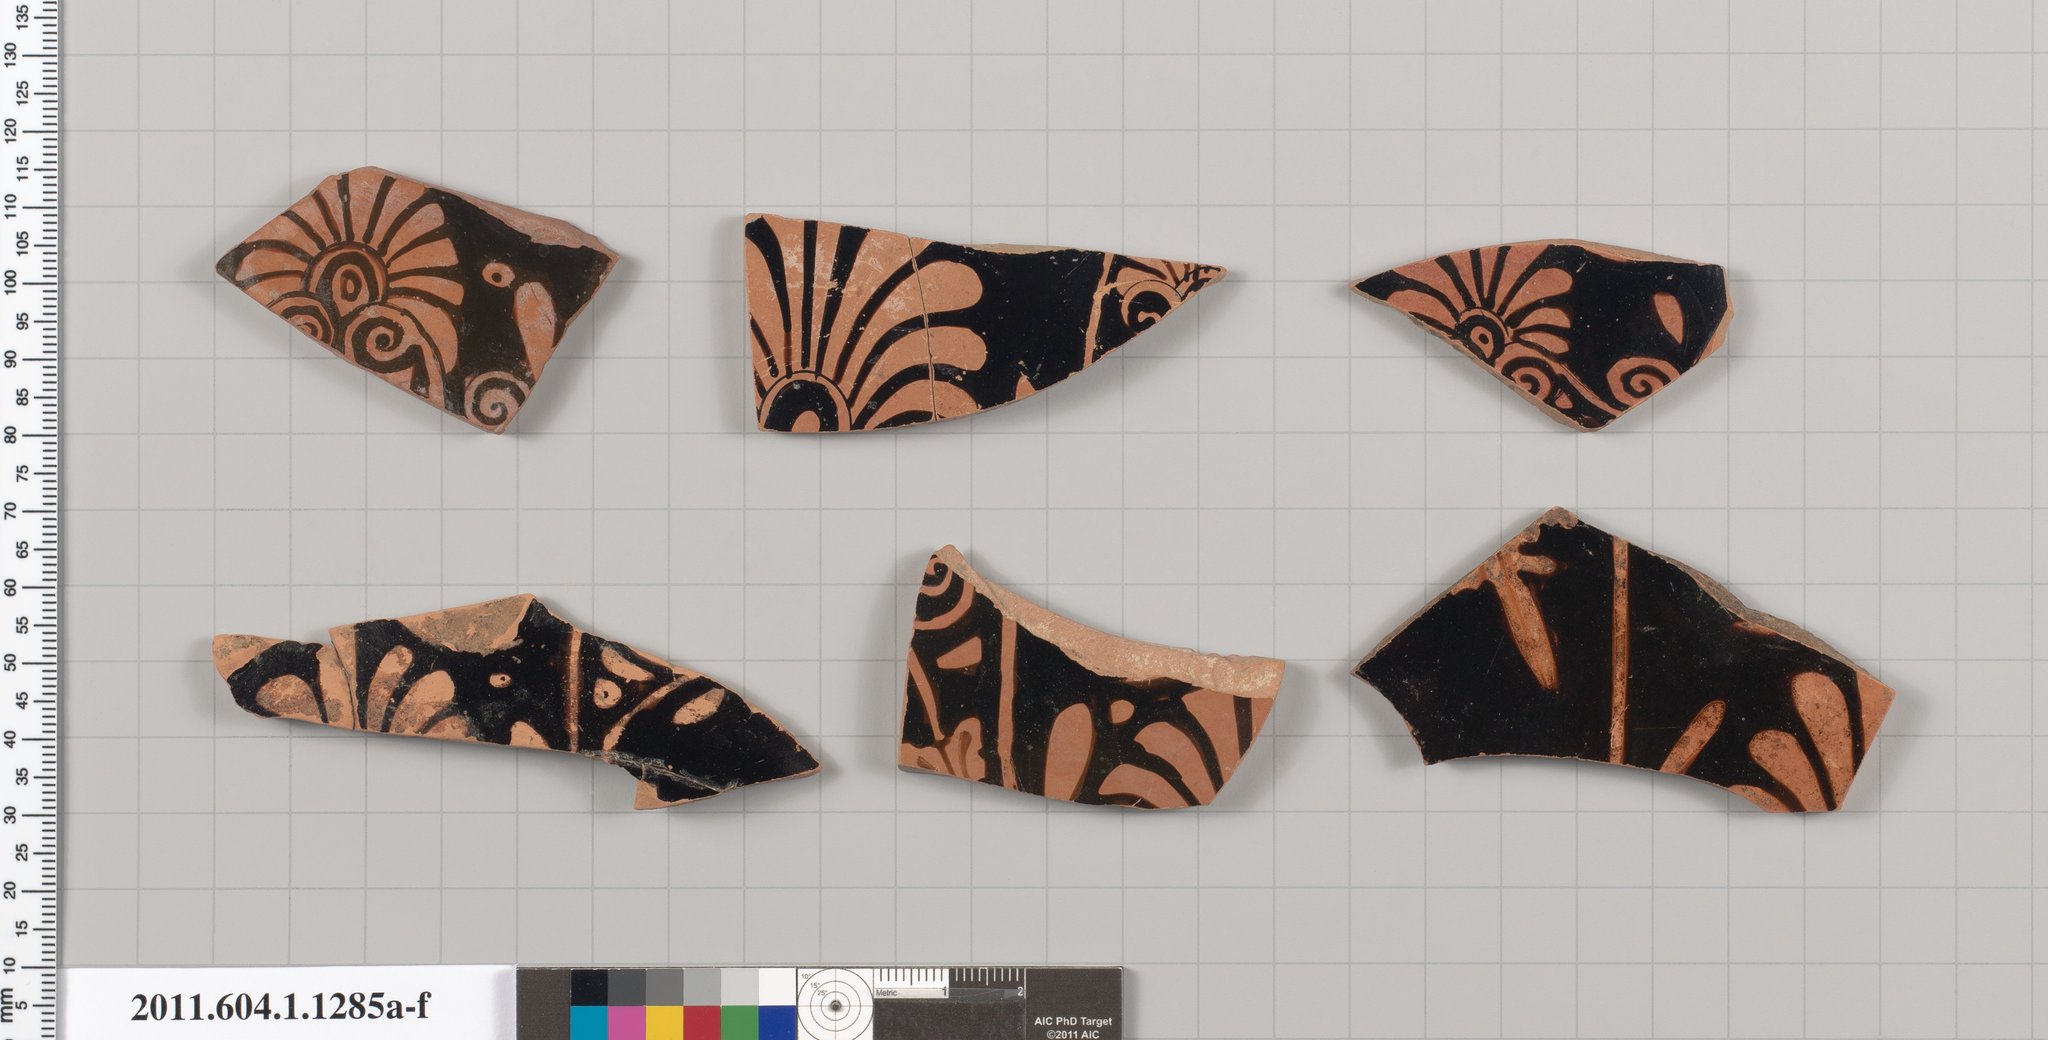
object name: kylix fragment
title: Terracotta fragments of kylikes (drinking cups)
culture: greek, attic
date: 500-401 BCE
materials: terracotta